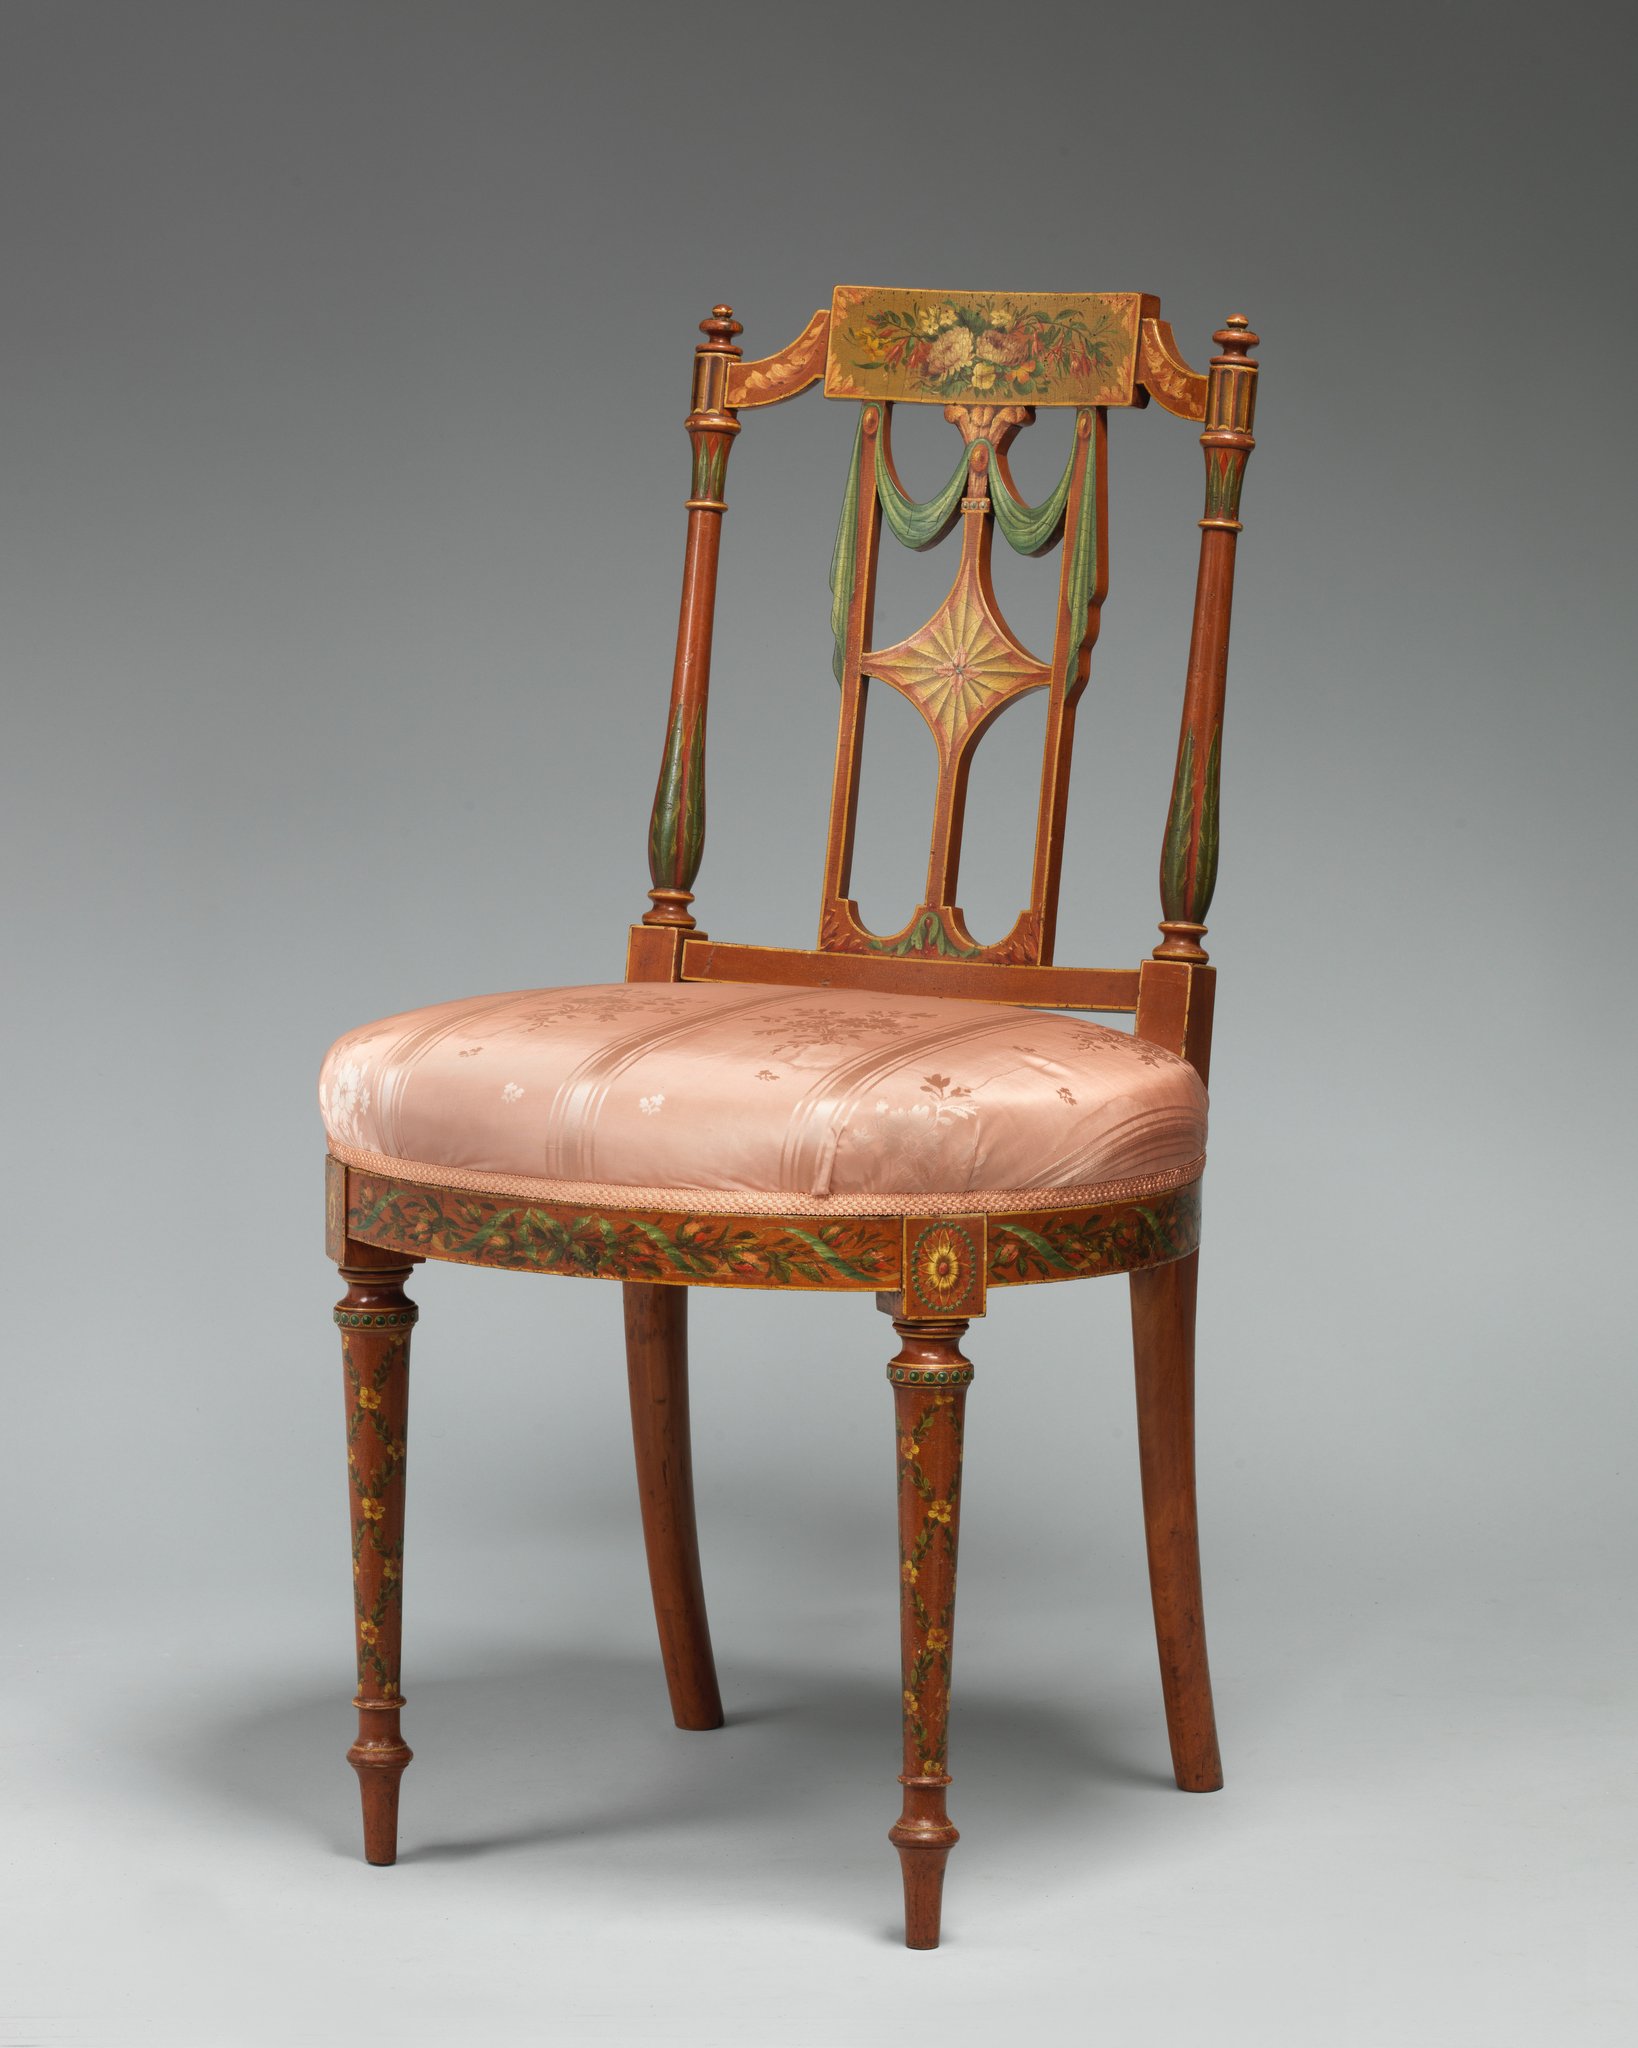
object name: side chair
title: Side chair (one of a pair)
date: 1795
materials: wood, silk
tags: flowers